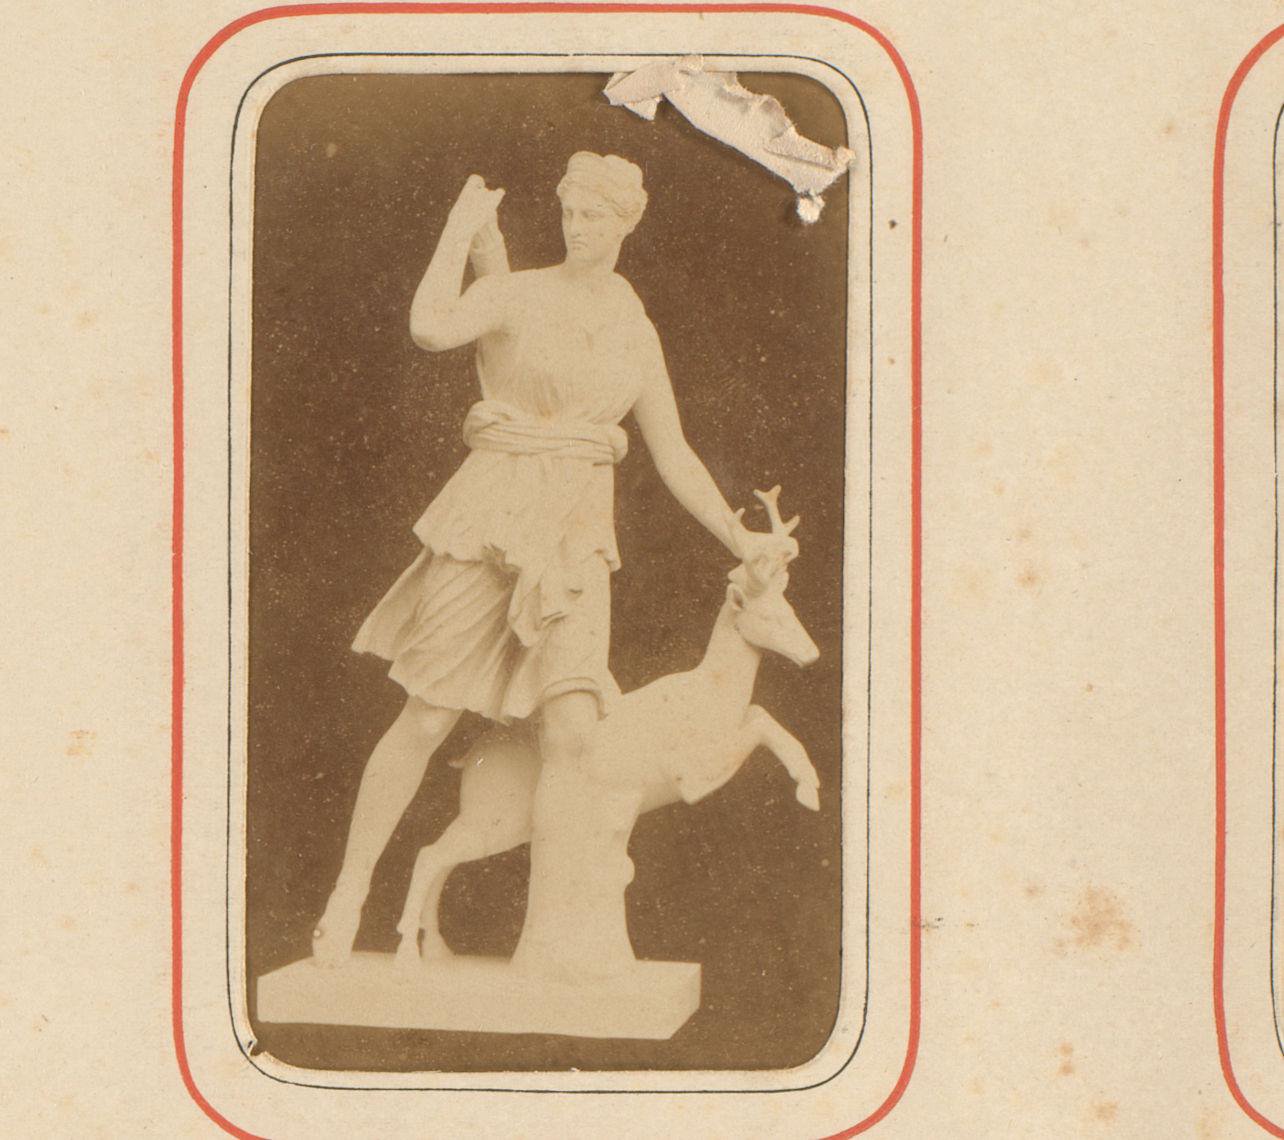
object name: photograph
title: Fotoreproductie van een gipsen kopie van Diana van Versailles in het Musée du Louvre in Parijs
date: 1870-1890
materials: cardboard, paper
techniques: albumen print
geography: paris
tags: sculpture